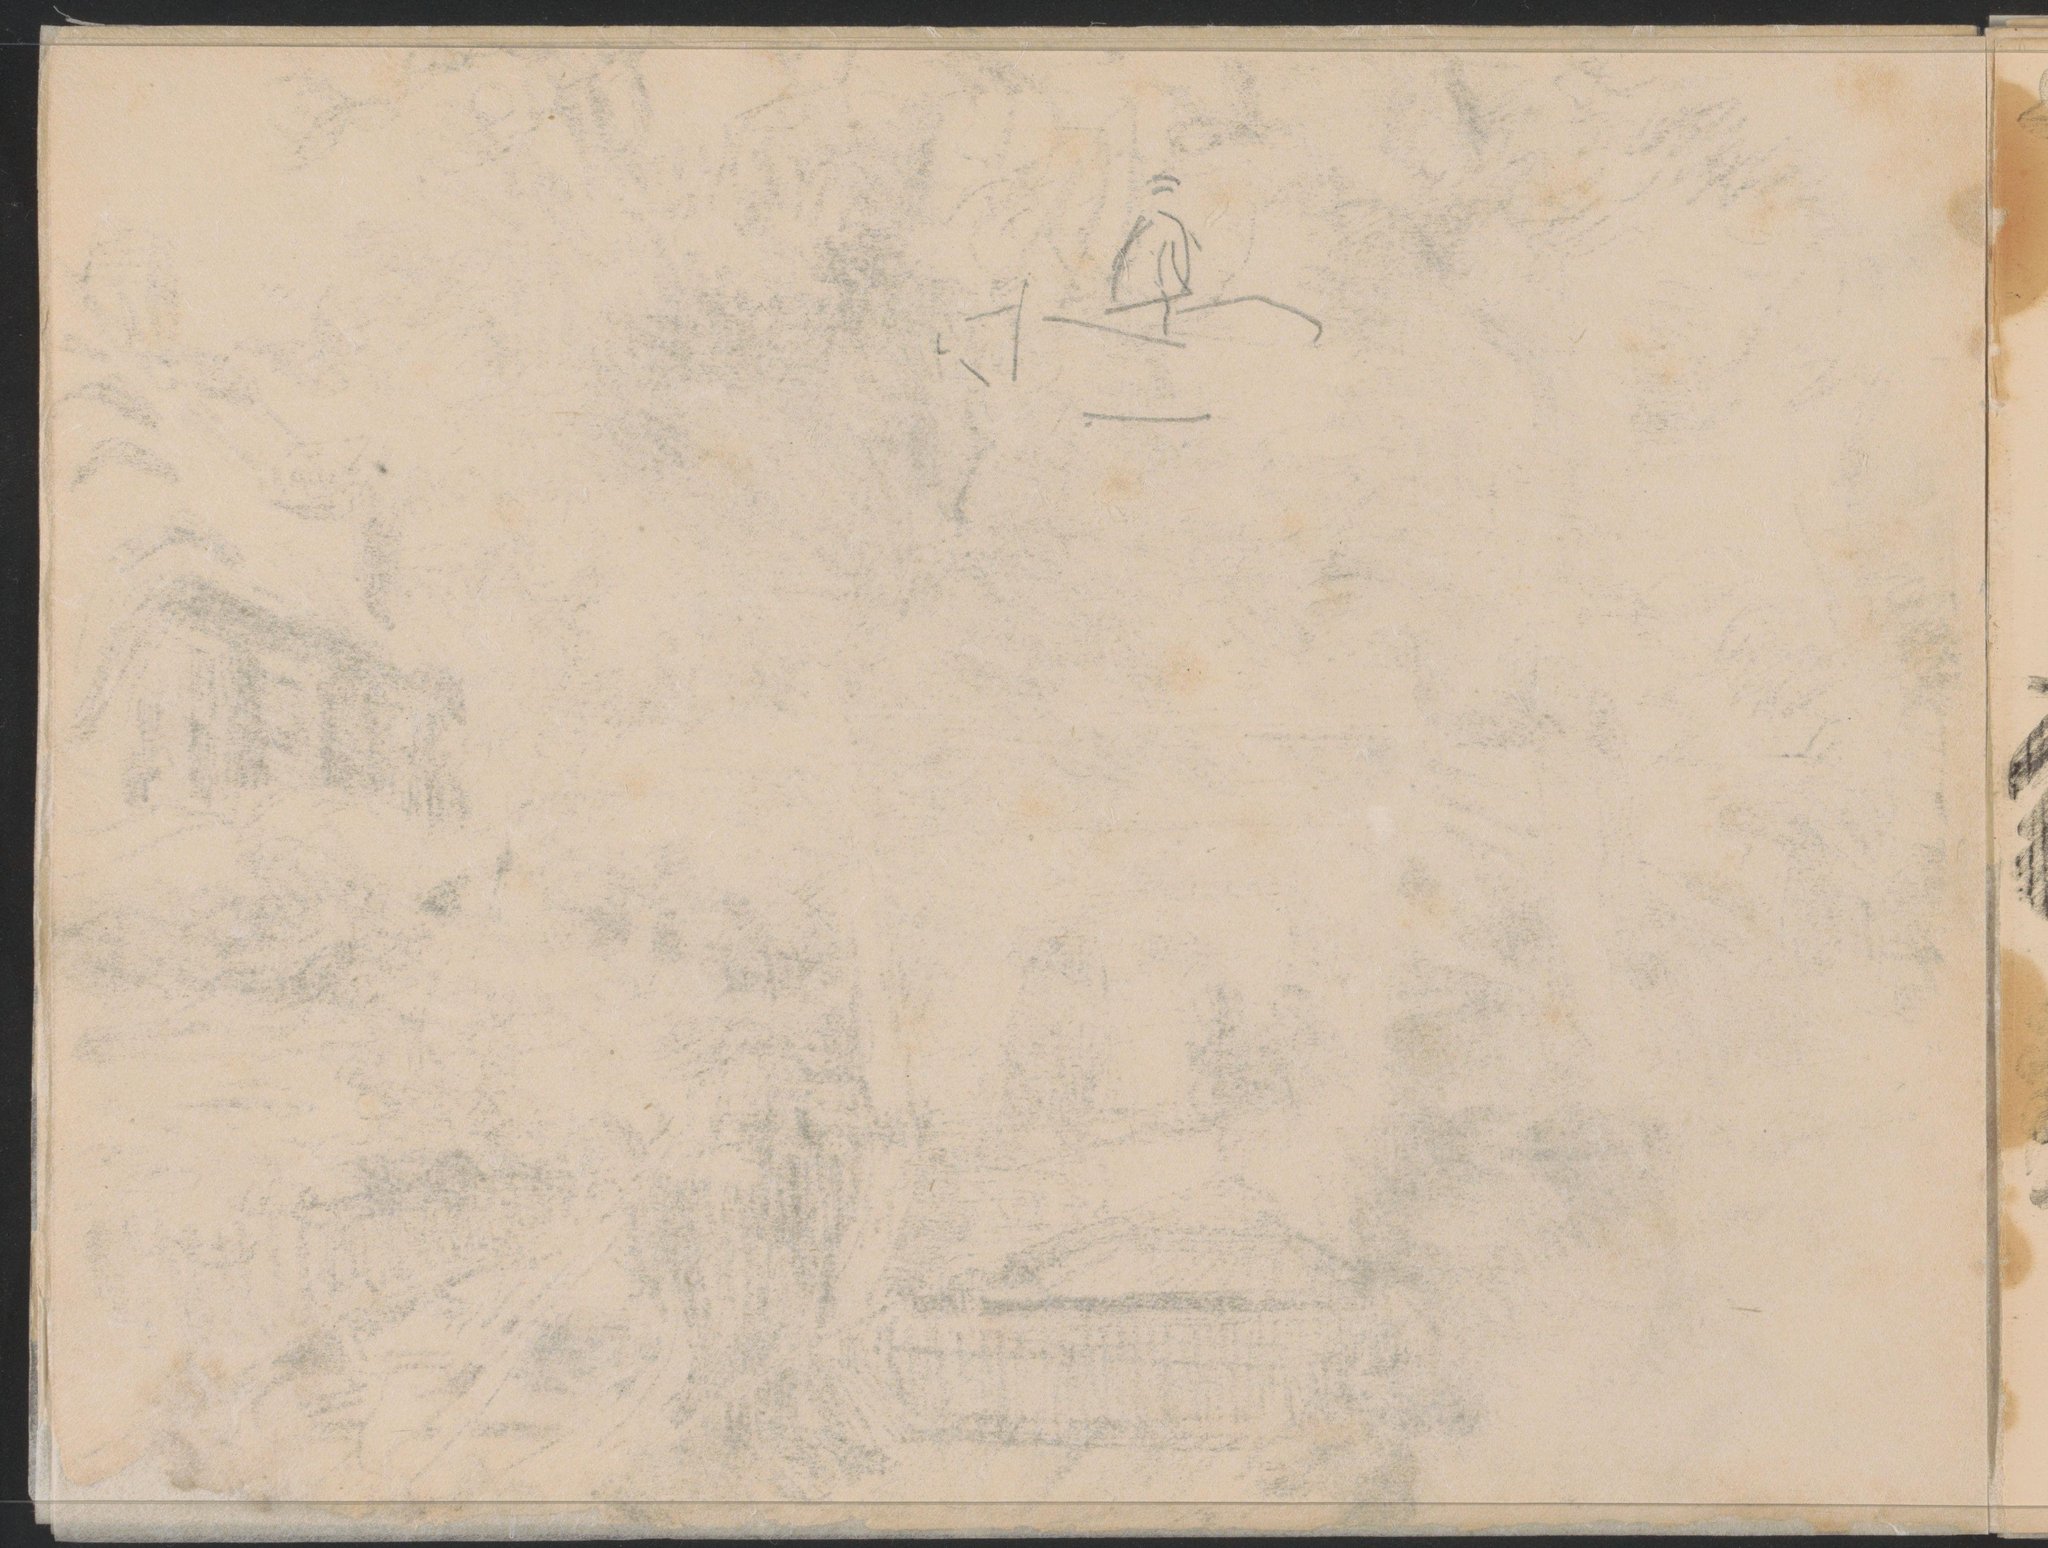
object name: sketchbook leaf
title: Man in een roeiboot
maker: willem bastiaan tholen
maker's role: draughtsman, painter, print maker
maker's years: 1860-1931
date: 1870-1931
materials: chalk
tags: standing figure, adult man, rowing-boat, canoe, etc.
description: Tevens een mogelijke abklatsch van een krijttekening met hutten en bomen of struiken. Blad 5 verso uit een schetsboek met 28 bladen.